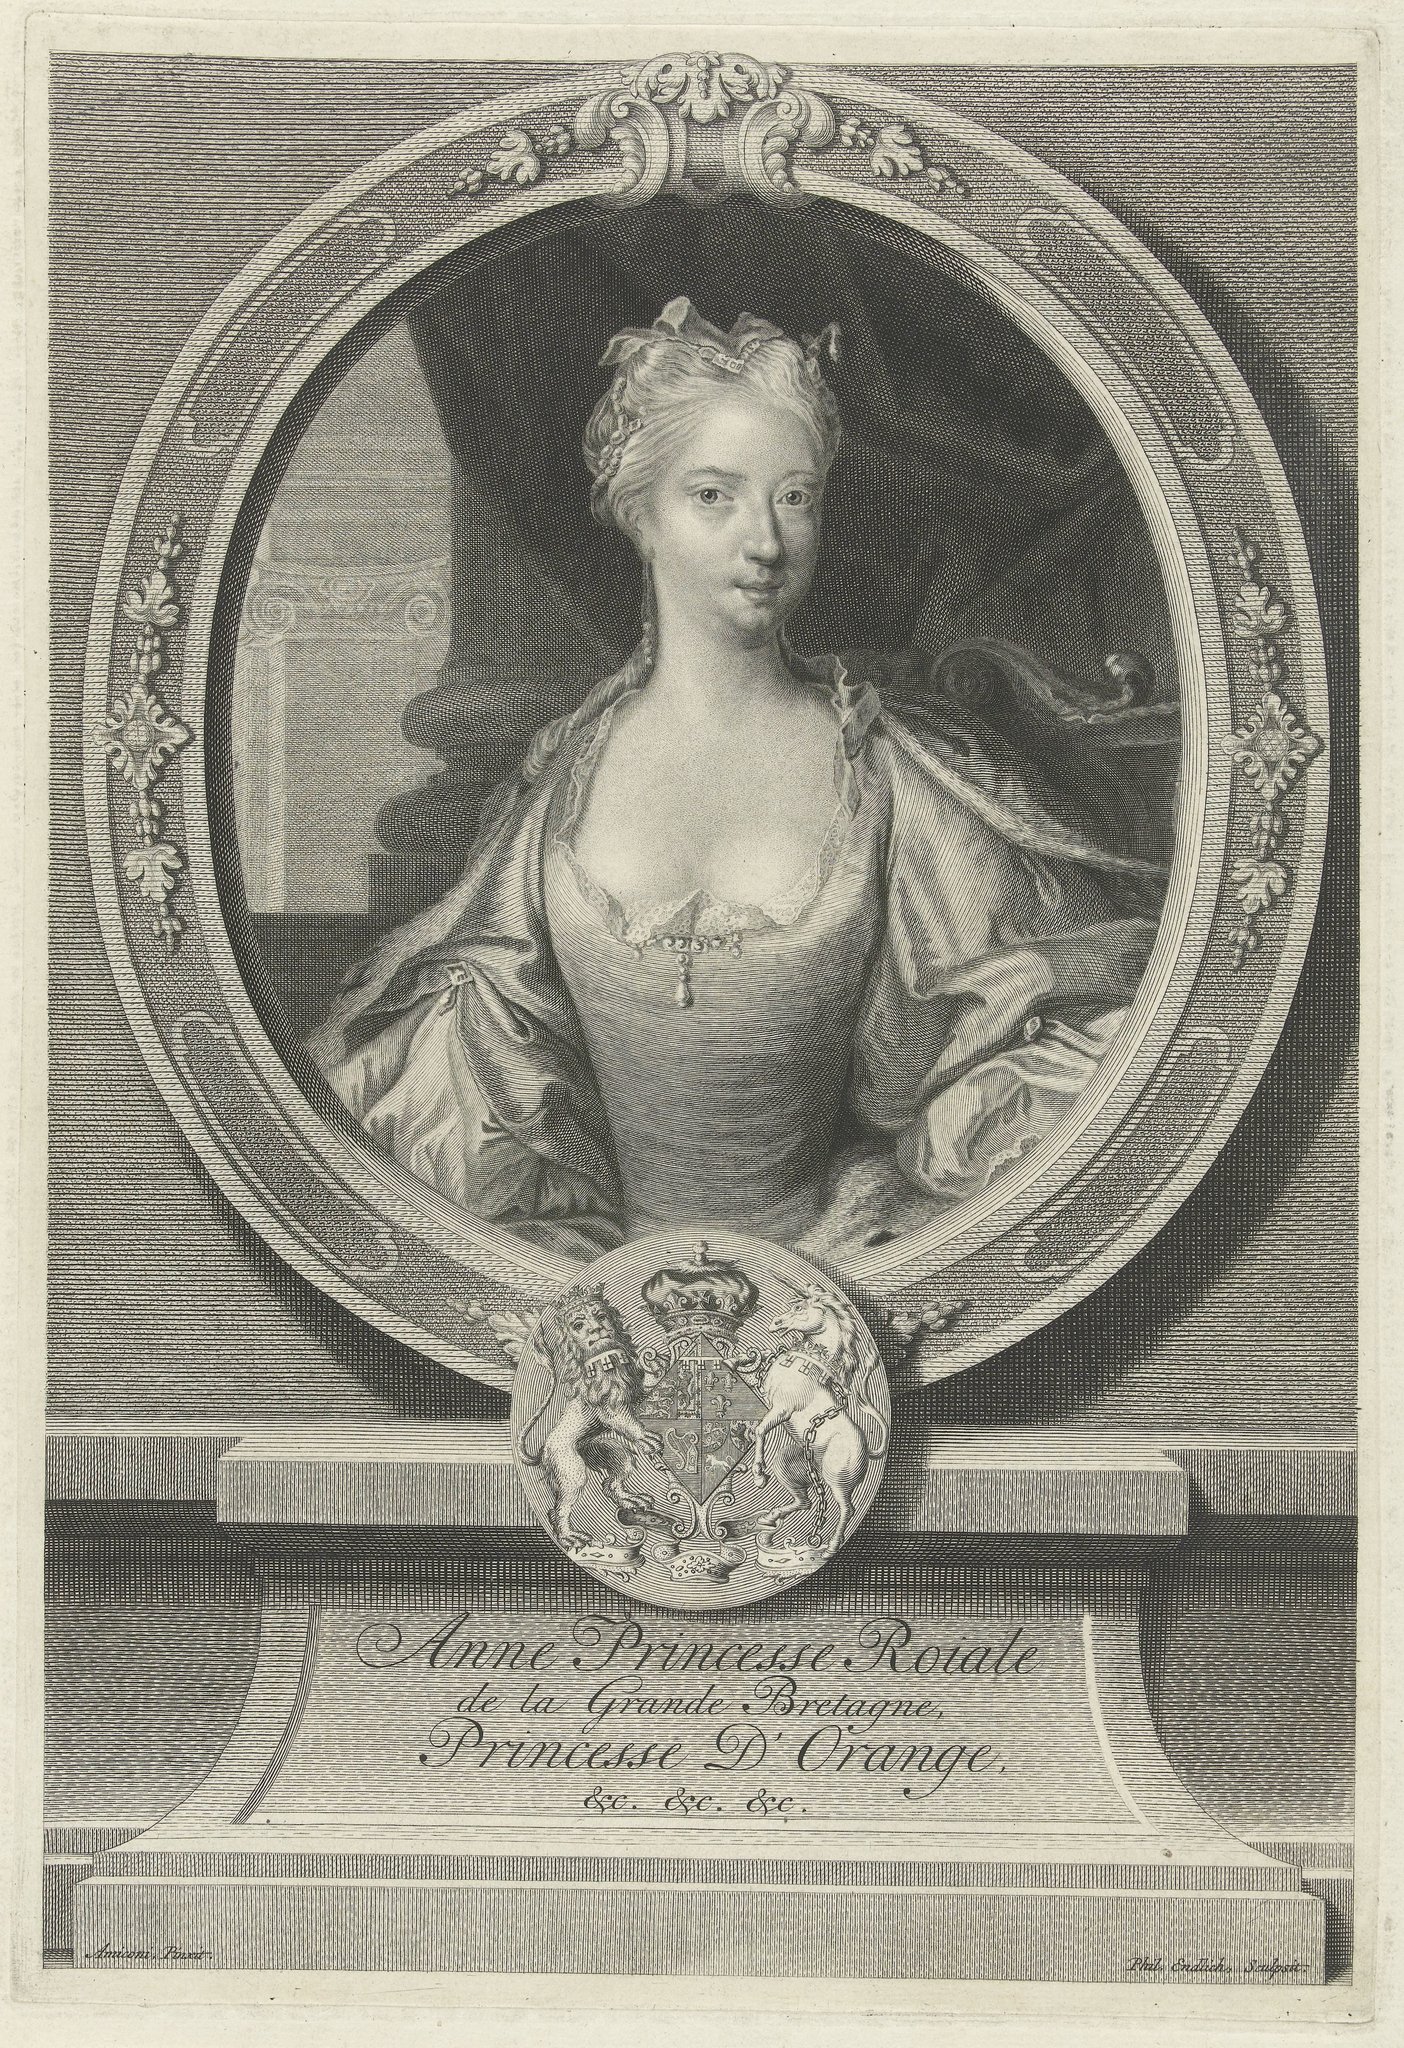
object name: print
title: Portret van Anna van Hannover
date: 1731-1748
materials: paper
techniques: engraving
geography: amsterdam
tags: anna van hannover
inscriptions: collector's mark: Lugt 240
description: Portret van Anna van Hannover (1709-1759), vrouw van Willem IV van Oranje-Nassau. Afgebeeld in ovale omlijsting boven een console, met het koninklijke wapen van Engeland waarop een leeuw en een eenhoorn staan afgebeeld.